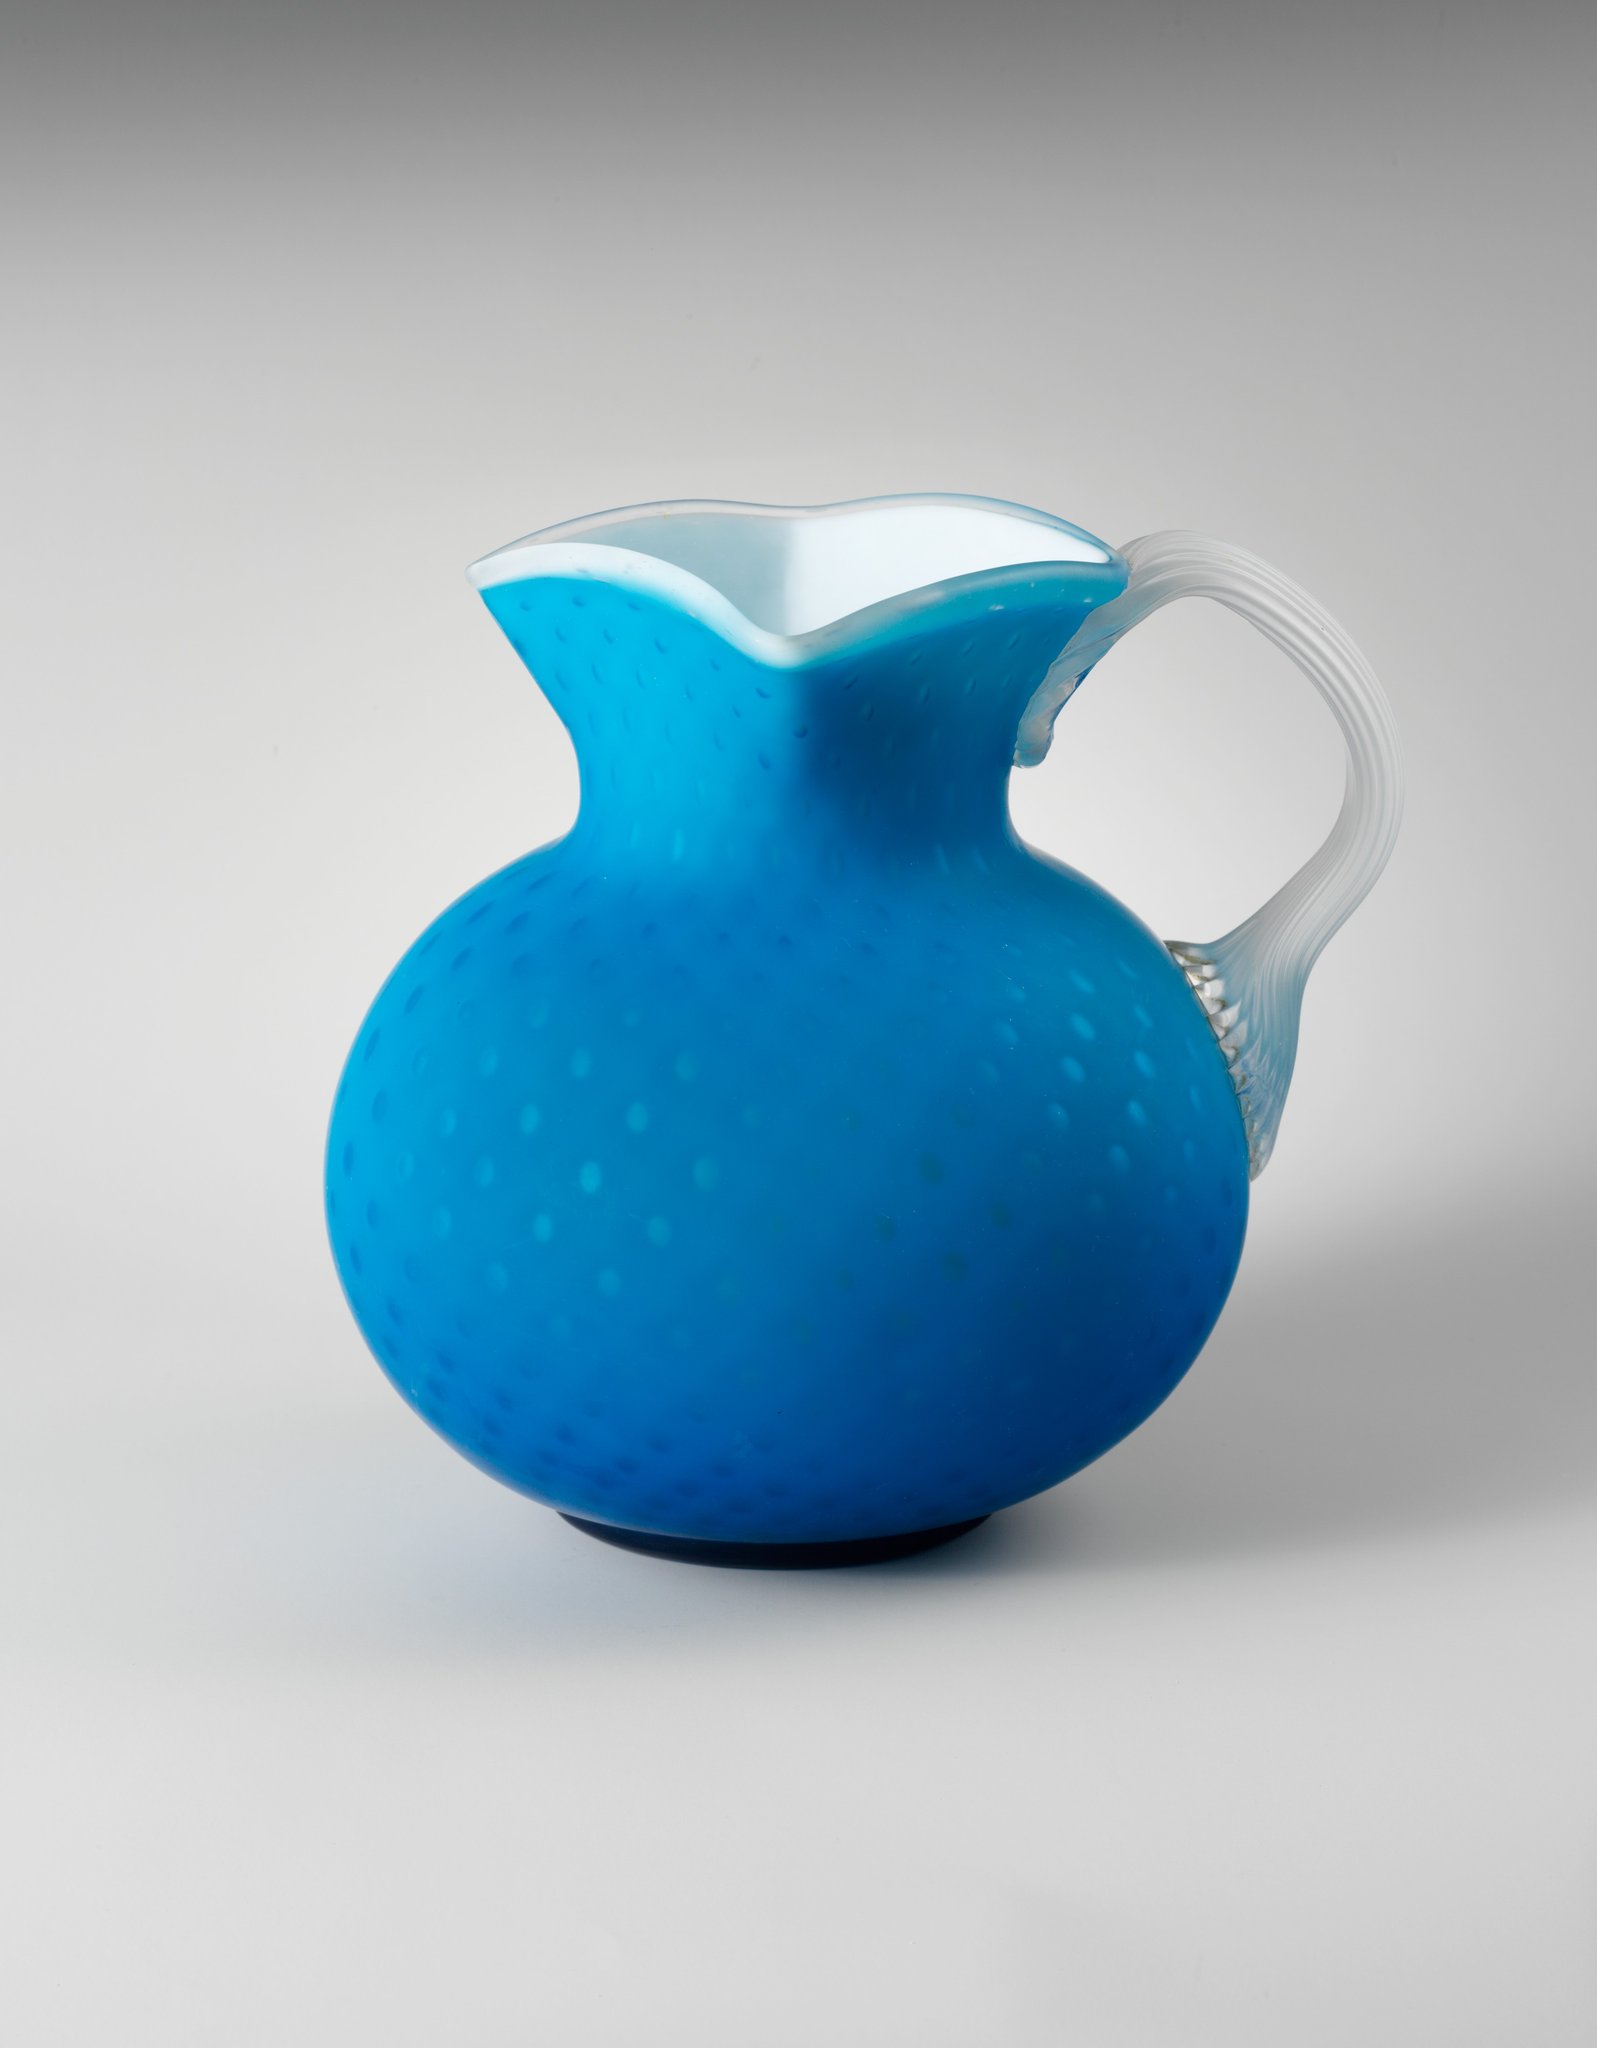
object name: pitcher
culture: american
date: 1885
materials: glass, textile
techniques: glassblowing